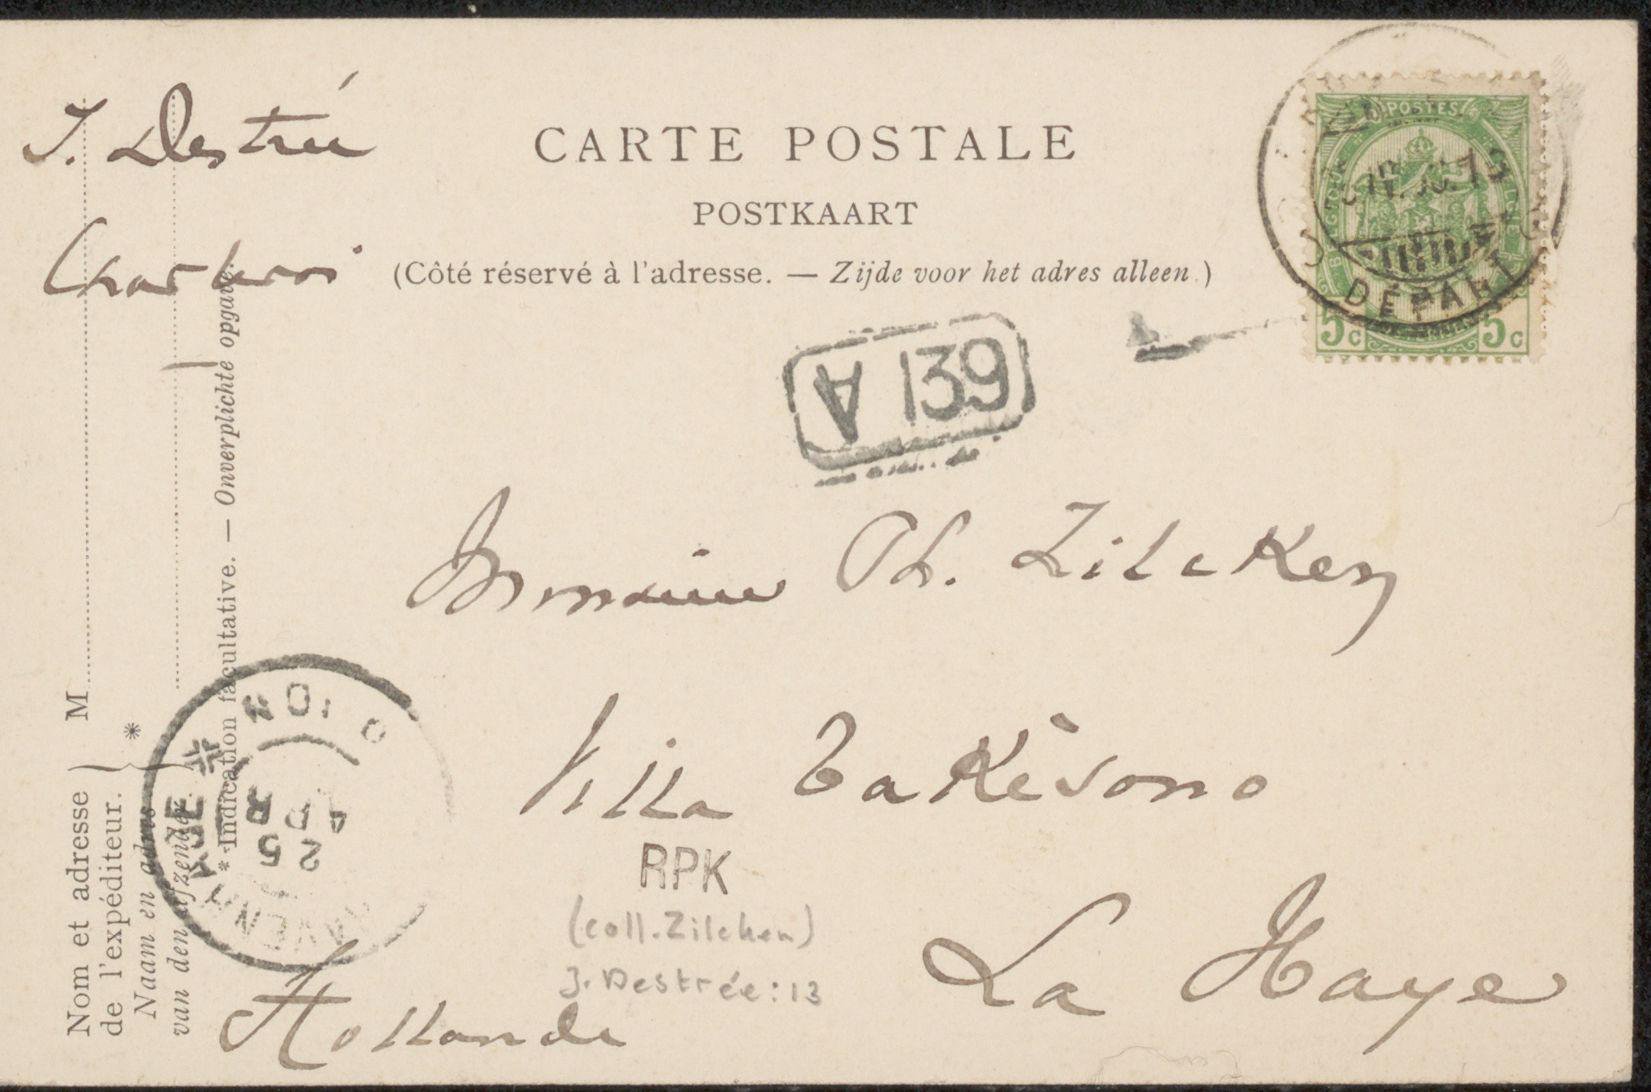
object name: postcard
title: Briefkaart aan Philip Zilcken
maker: jules destrée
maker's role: politician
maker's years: 1863-1936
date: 1873-1930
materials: cardboard, ink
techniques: pen, writing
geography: charleroi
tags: the hague, painter, draughtsman, philip zilcken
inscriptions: collector's mark: ‘RPK’